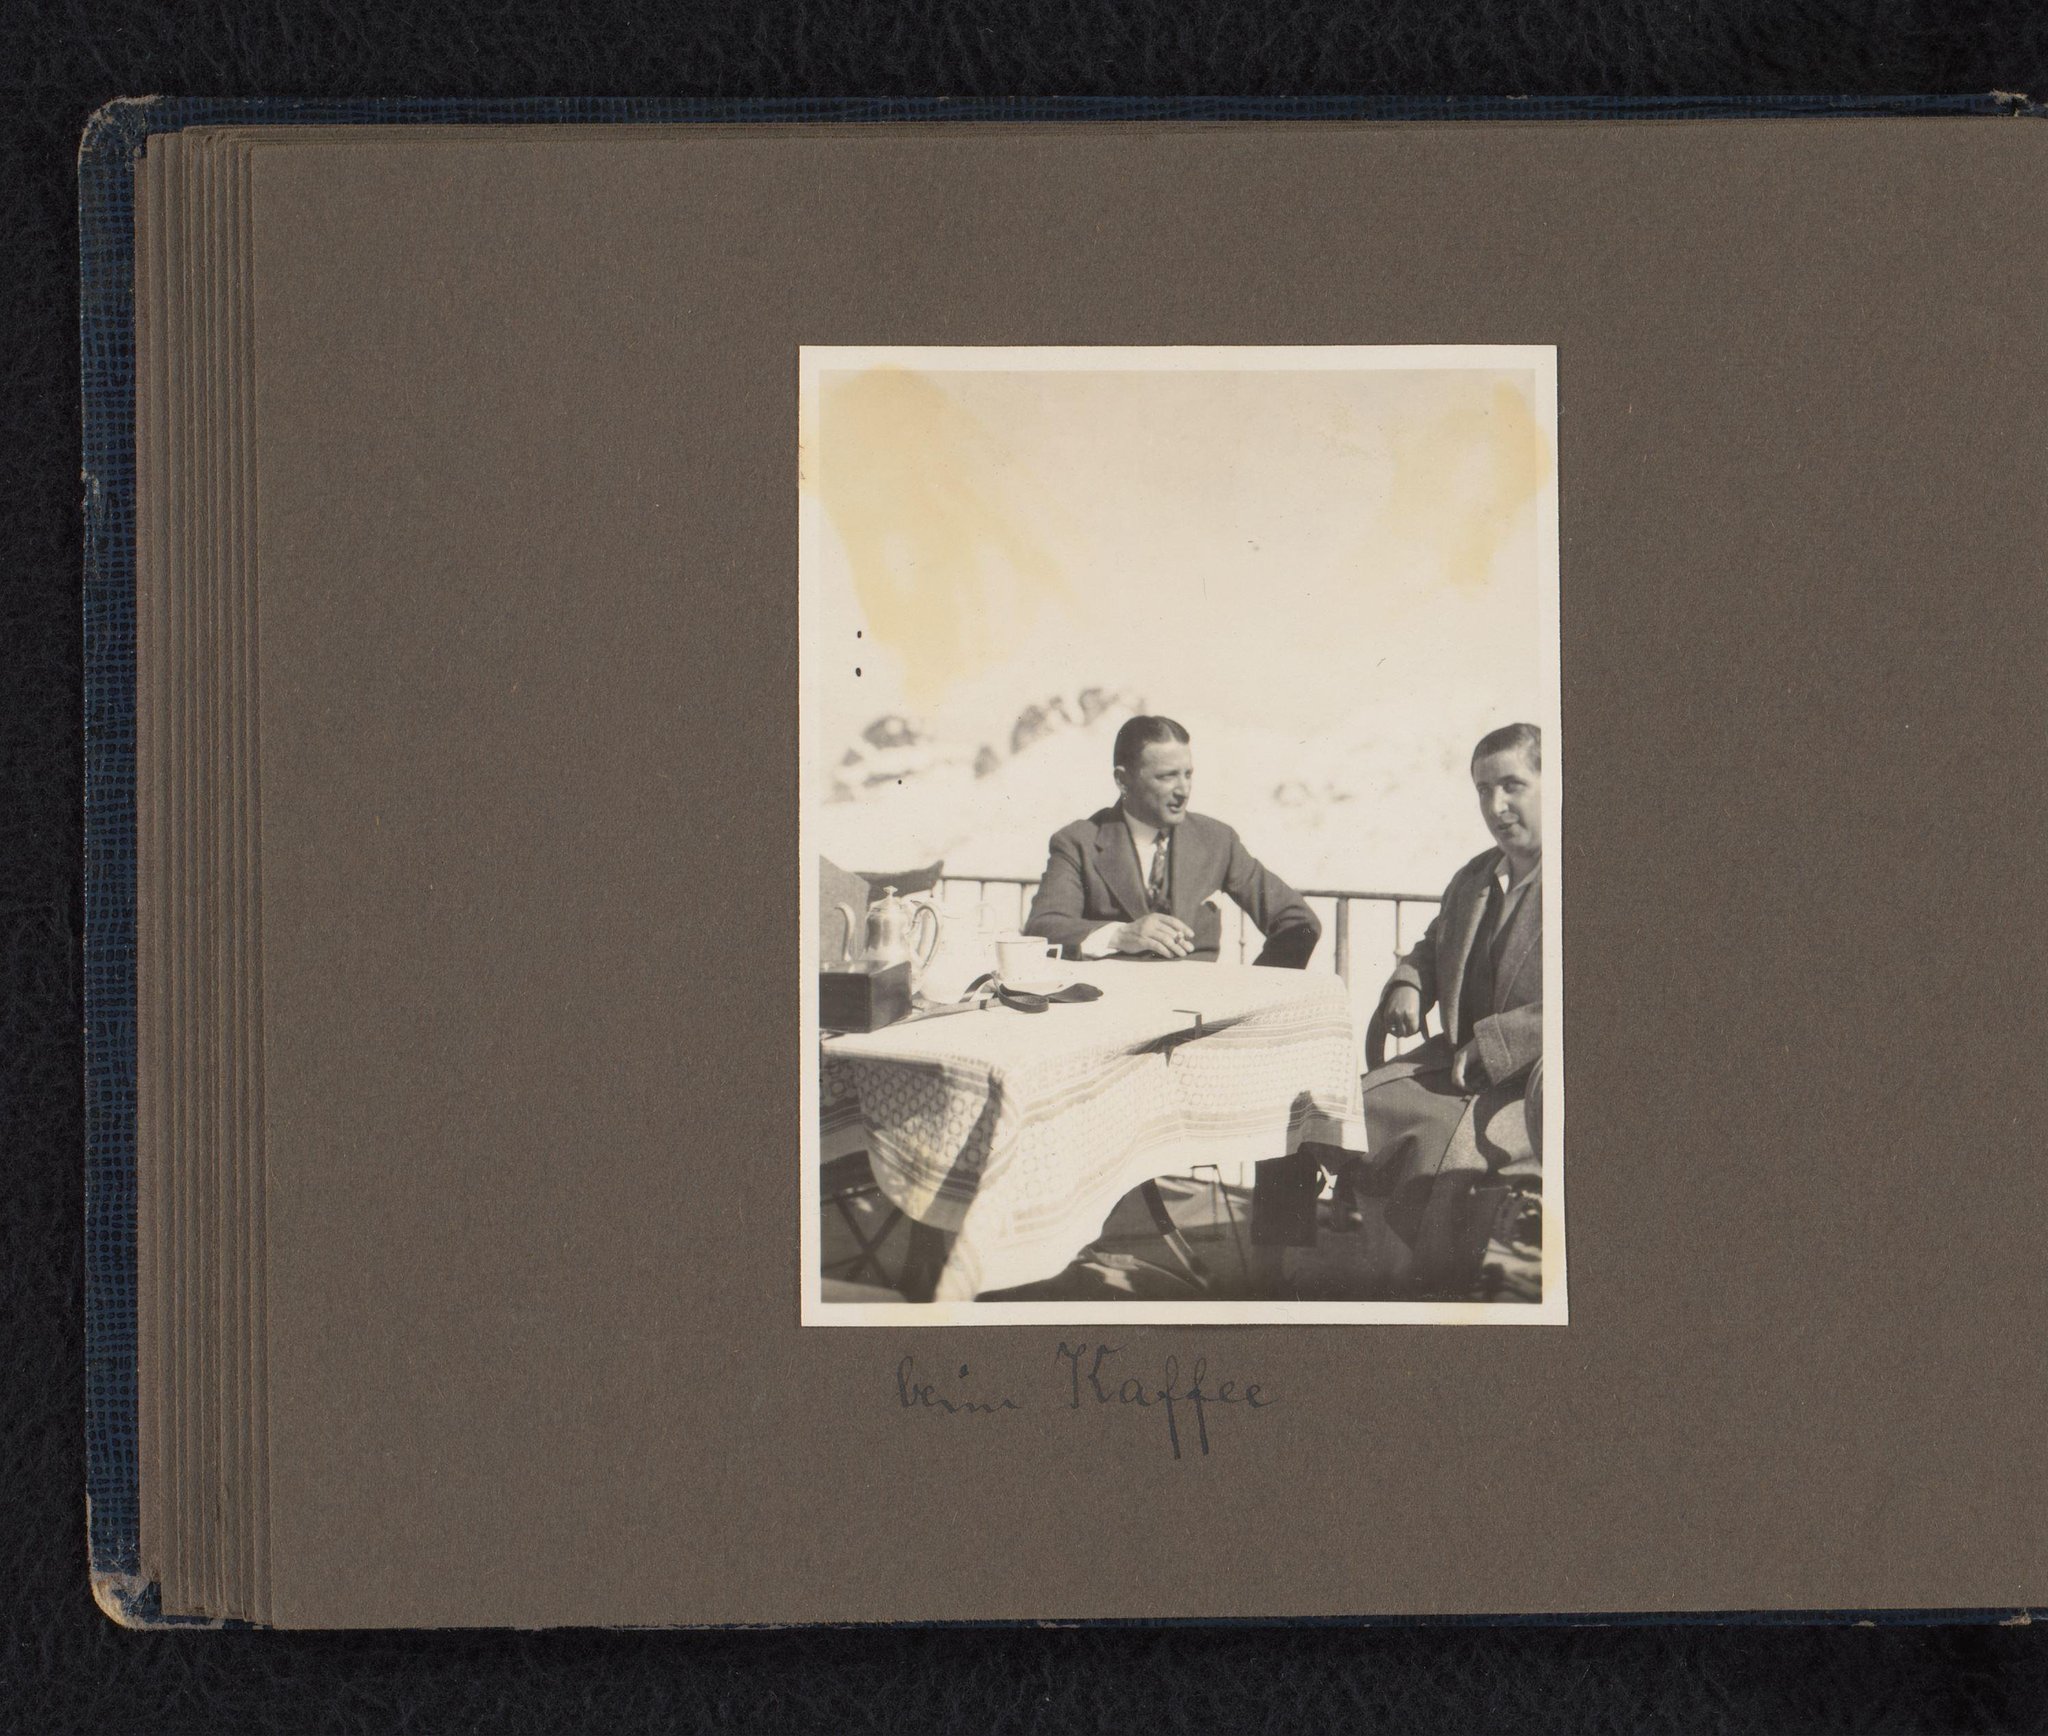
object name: photograph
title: Else Wachenheimer-Moos drinkt koffie op een terras met haar broer Willy Moos, tijdens een vakantie van Eugen Wachenheimer en zijn echtgenote Else Wachenheimer-Moos door Zwitserland, augustus 1928, omgeving Montreux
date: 1908-1928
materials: paper, photographic support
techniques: gelatin silver print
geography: switzerland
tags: else wachenheimer-moos, willy moos, the family travelling, on holiday, morning coffee - cc - out of doors, switzerland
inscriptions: inscription: ‘beim Kaffee’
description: Albumblad bevat een foto van Else Wachenheimer-Moos en Willy Moos. Uit album half formaat, blauw kunstlederen omslag met koordbinding.